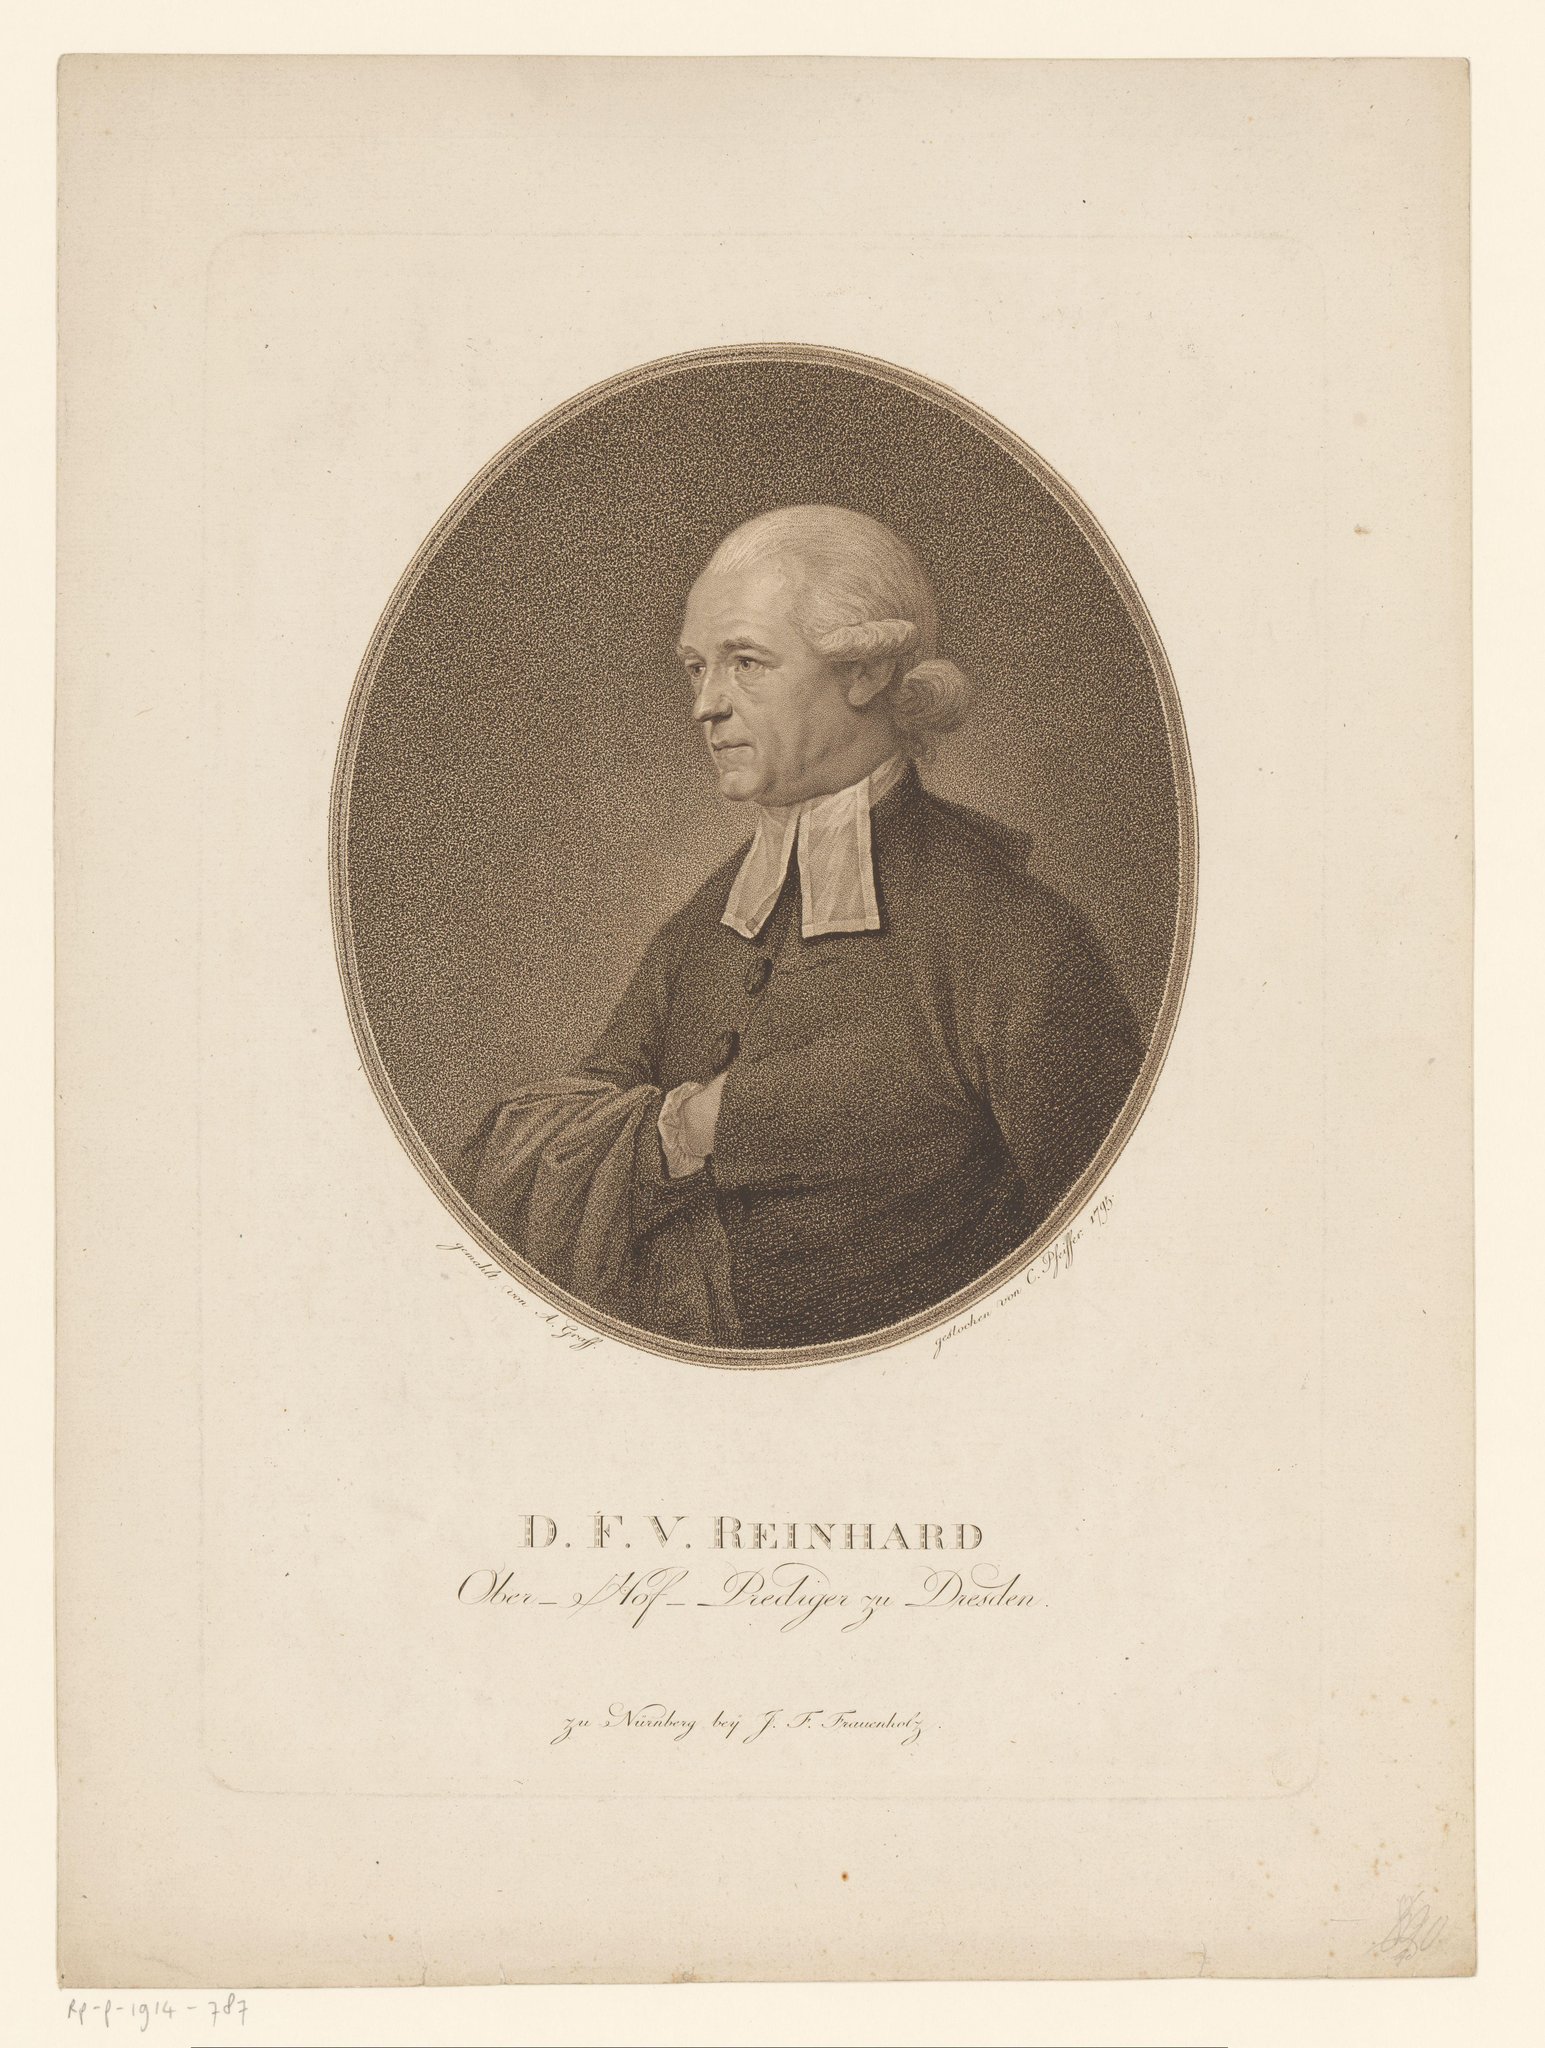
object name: print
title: Portret van Franz Volkmar Reinhard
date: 1779-1829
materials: paper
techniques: engraving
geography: nuremberg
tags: historical persons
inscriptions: collector's mark: Lugt 2228